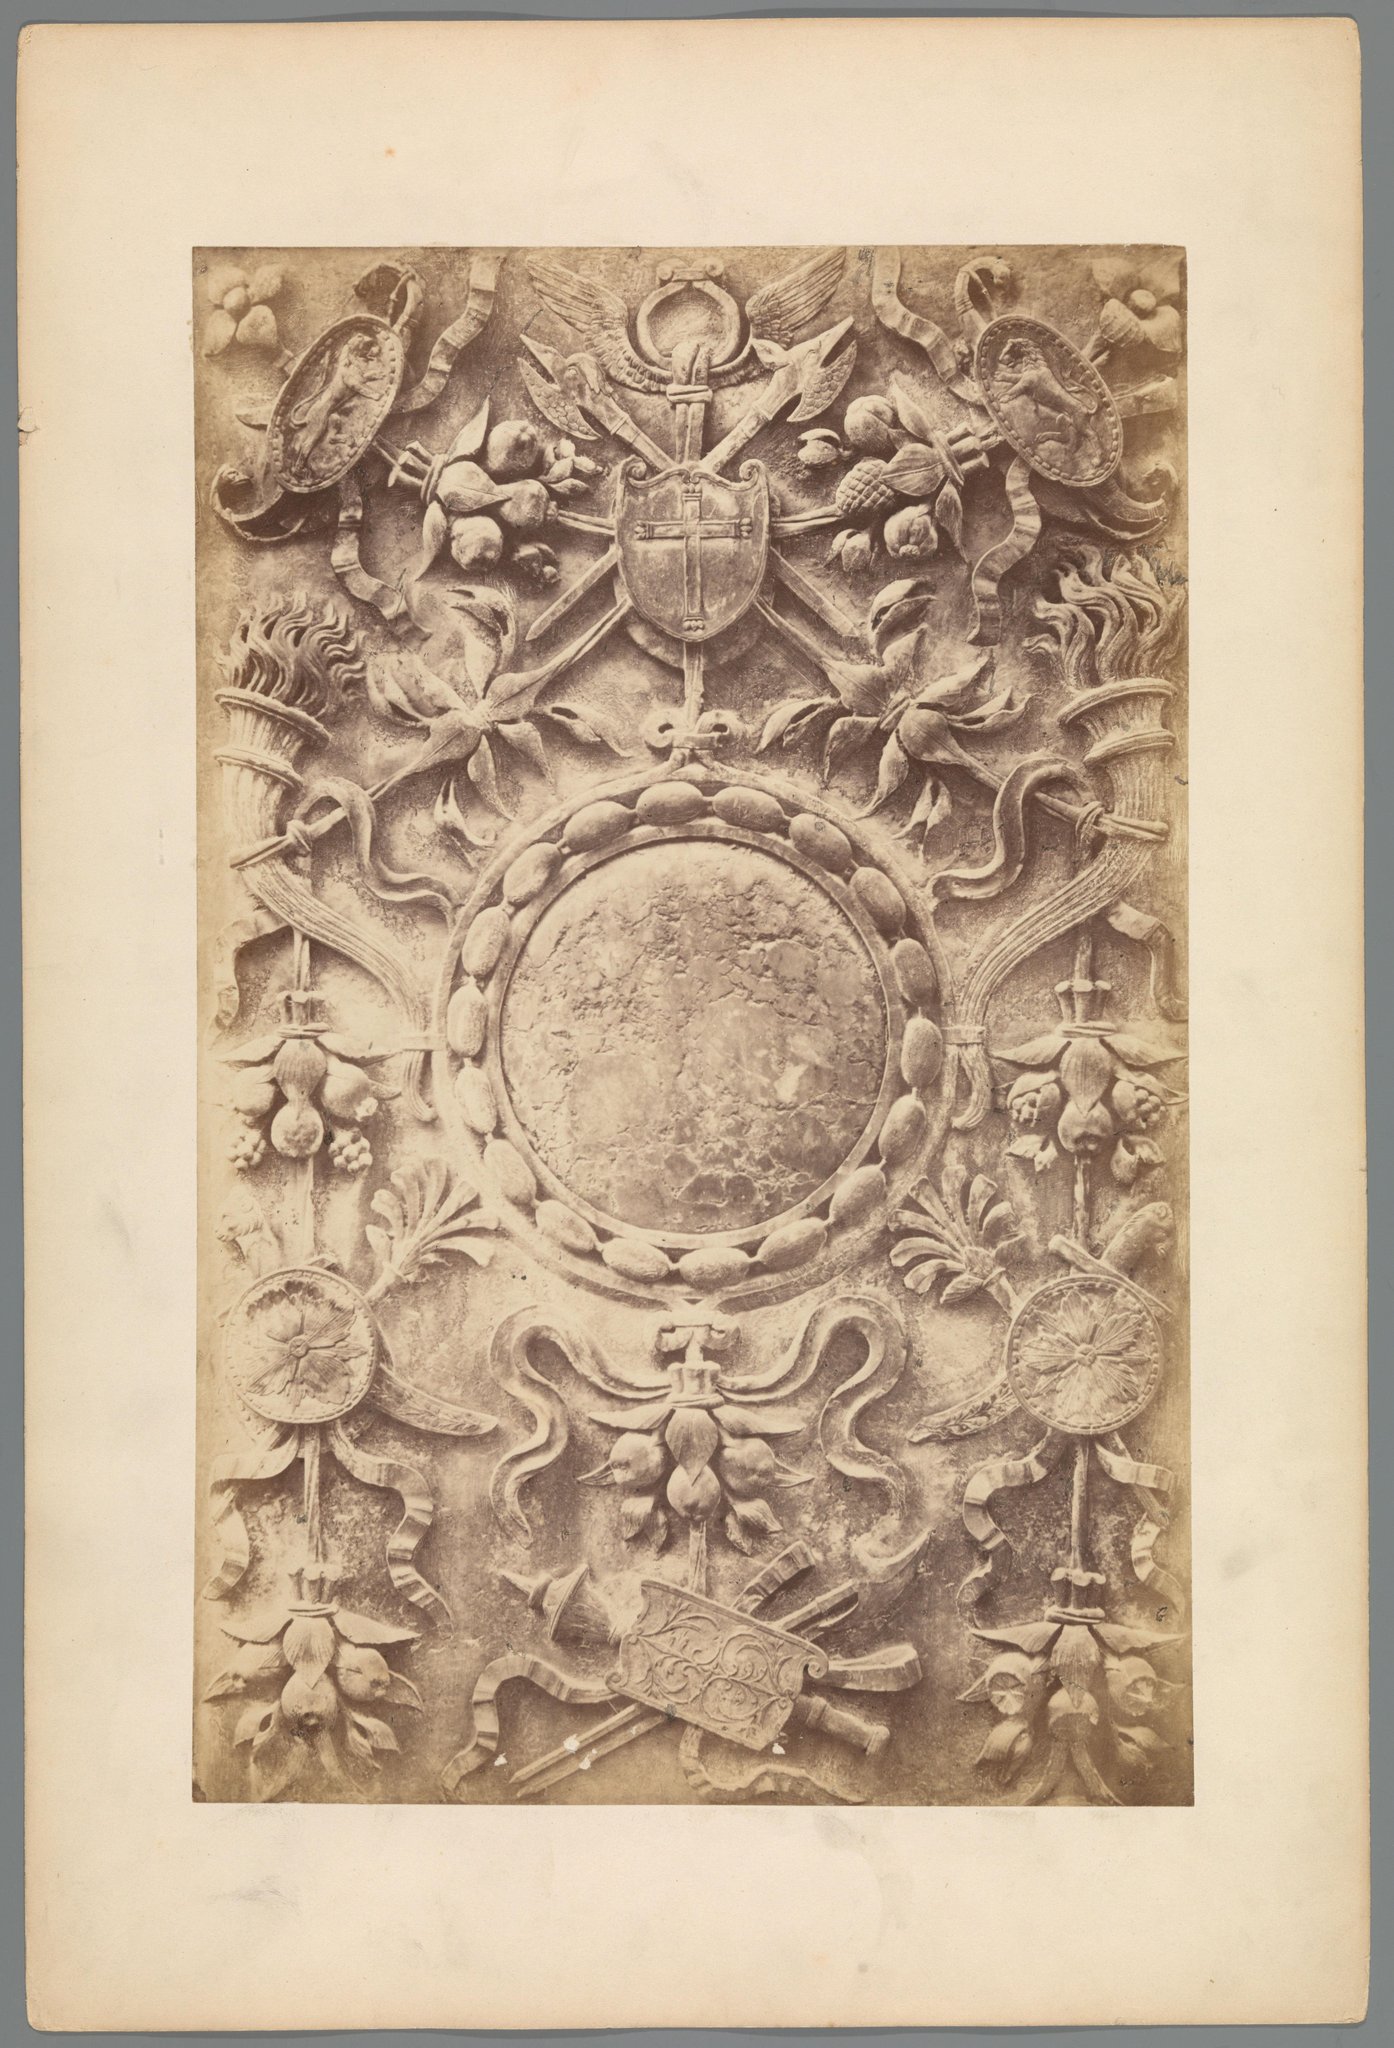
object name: photograph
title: Reliëf met fruit, fakkels, wapenschilden en speren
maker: Anonymous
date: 1875-1900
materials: cardboard, photographic support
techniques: albumen print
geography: europe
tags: coat of arms (as symbol of the state, etc.), torch, fruits and vegetables ~ ornament, sculpture (+ relief ~ sculpture), europe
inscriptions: collector's mark: Lugt 3937